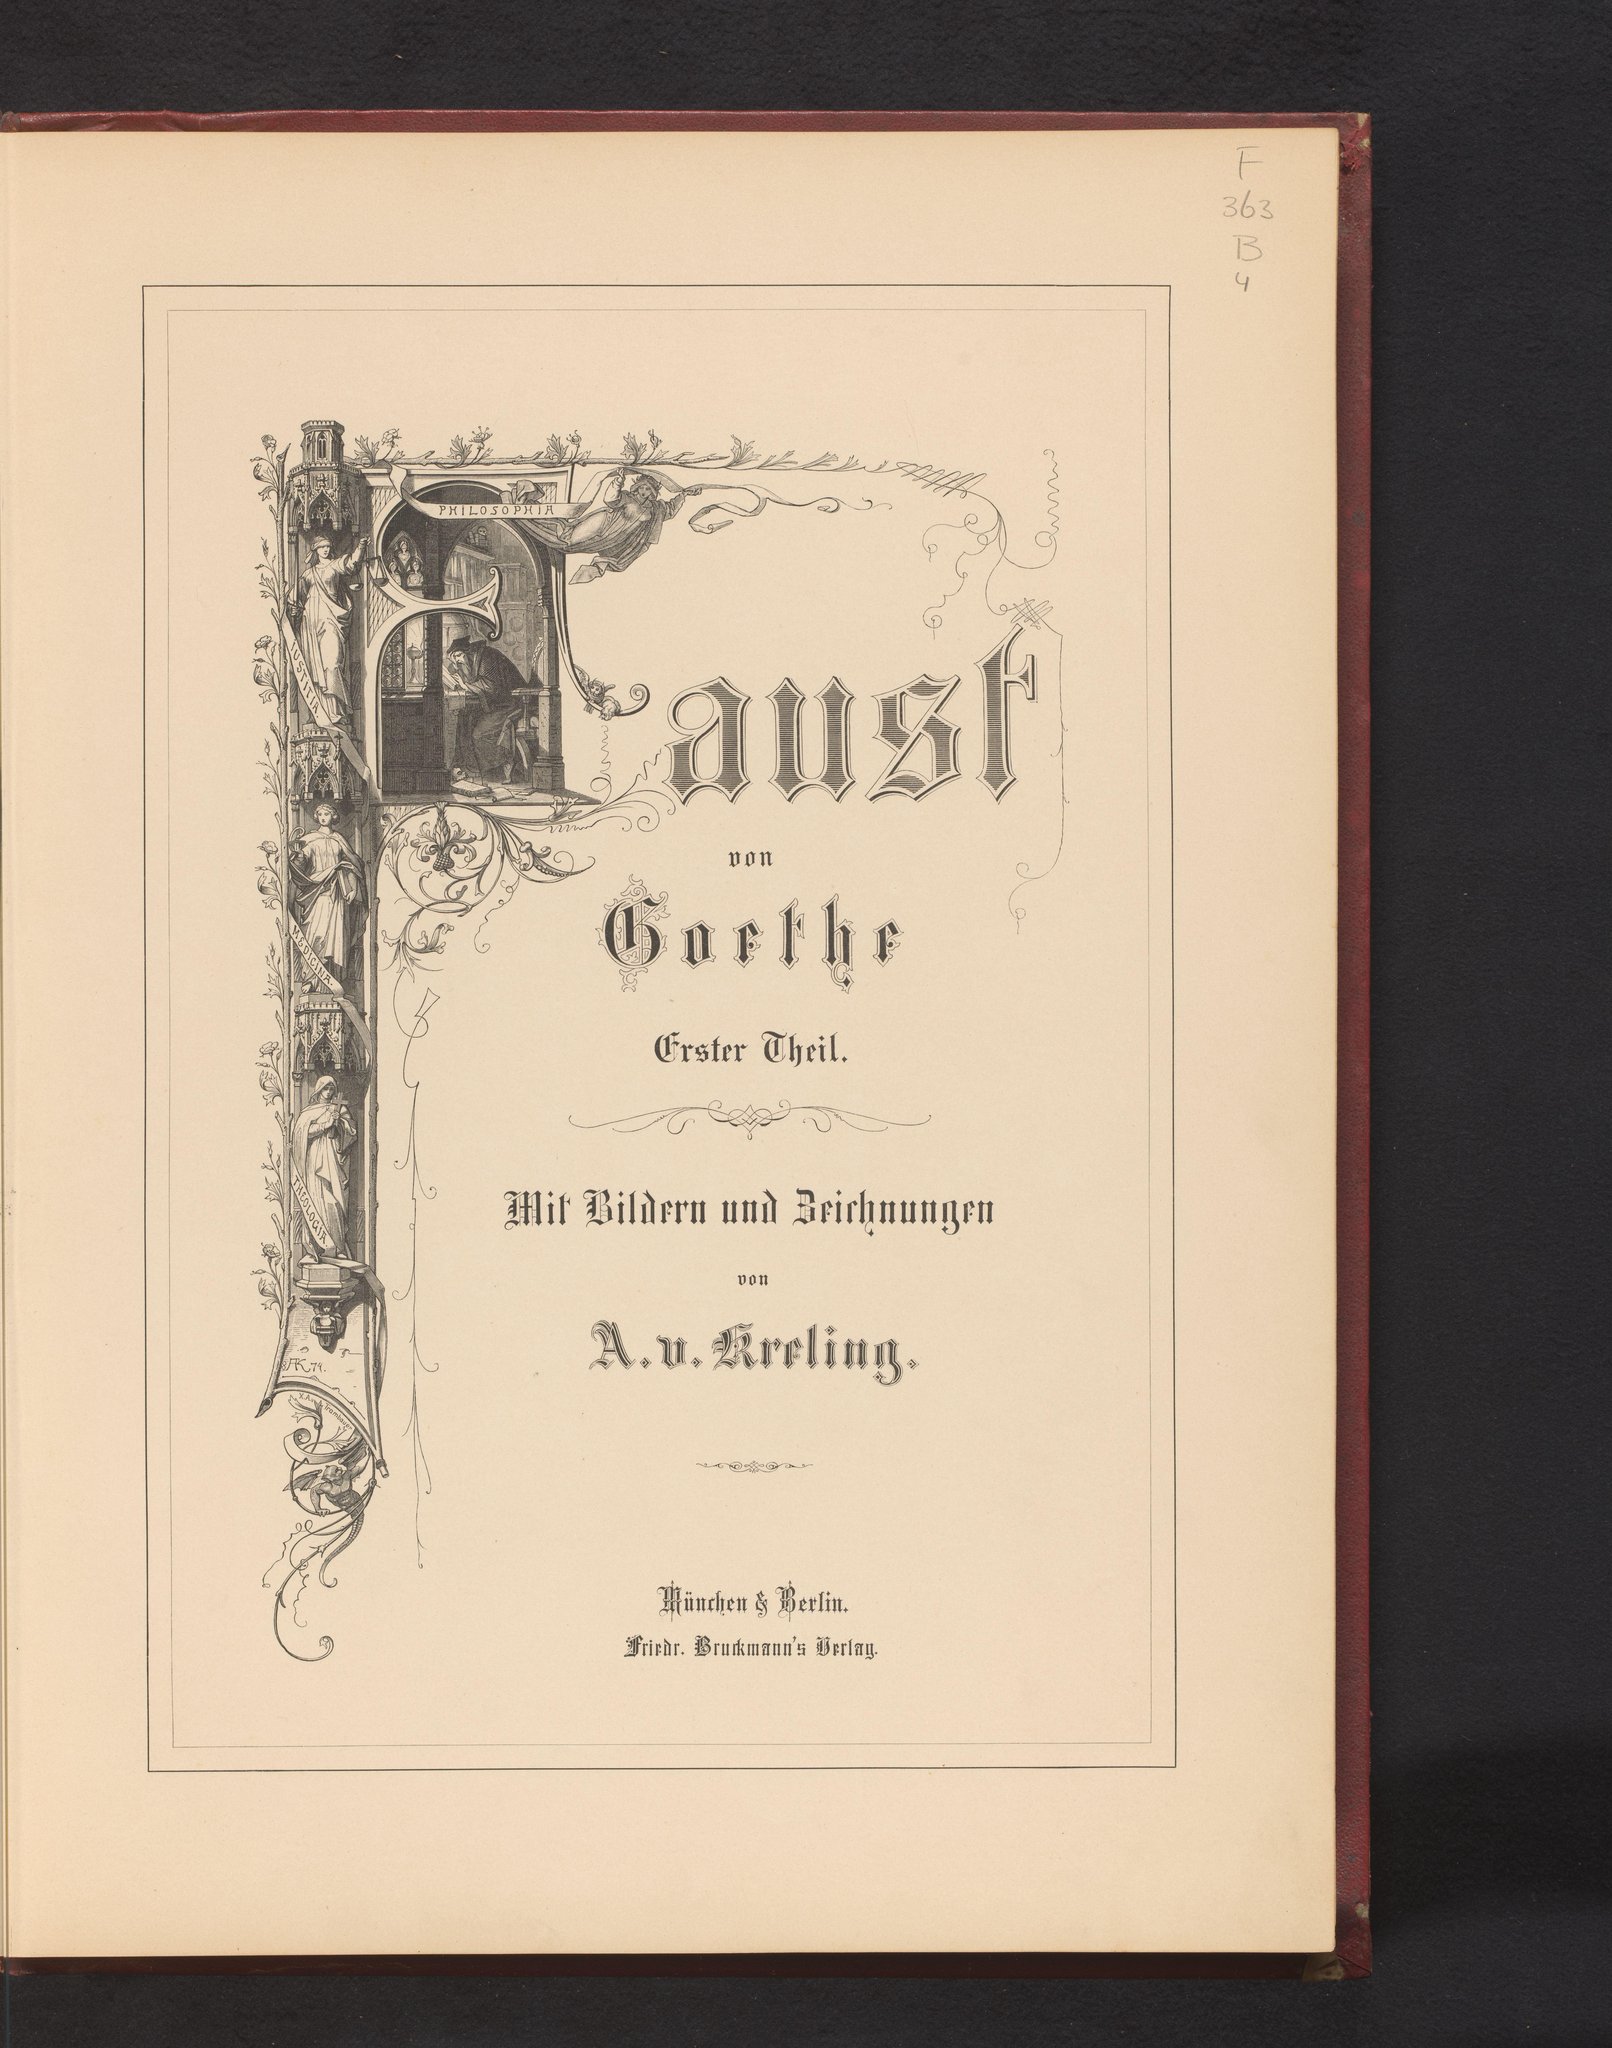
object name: book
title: Faust : erster Theil / von Goethe; mit Bildern und Zeichnungen von A. v. Kreling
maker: johann wolfgang von goethe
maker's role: draughtsman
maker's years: 1749-1832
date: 1877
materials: cardboard, leather, linen, paper, photographic support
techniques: albumen print, decorated paper, printing, engraving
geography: munich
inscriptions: date: ‘[..]N/ 1993’